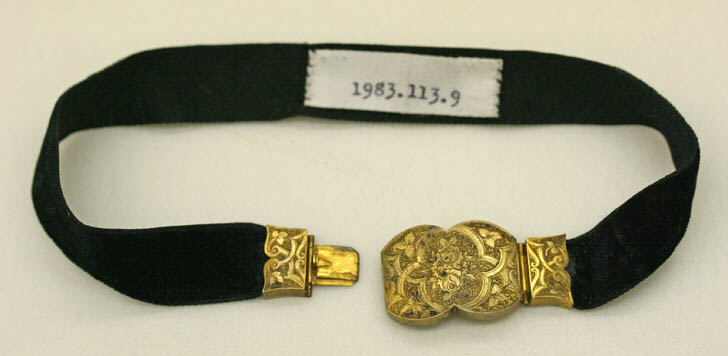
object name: choker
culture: american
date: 1870-1879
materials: metal, silk